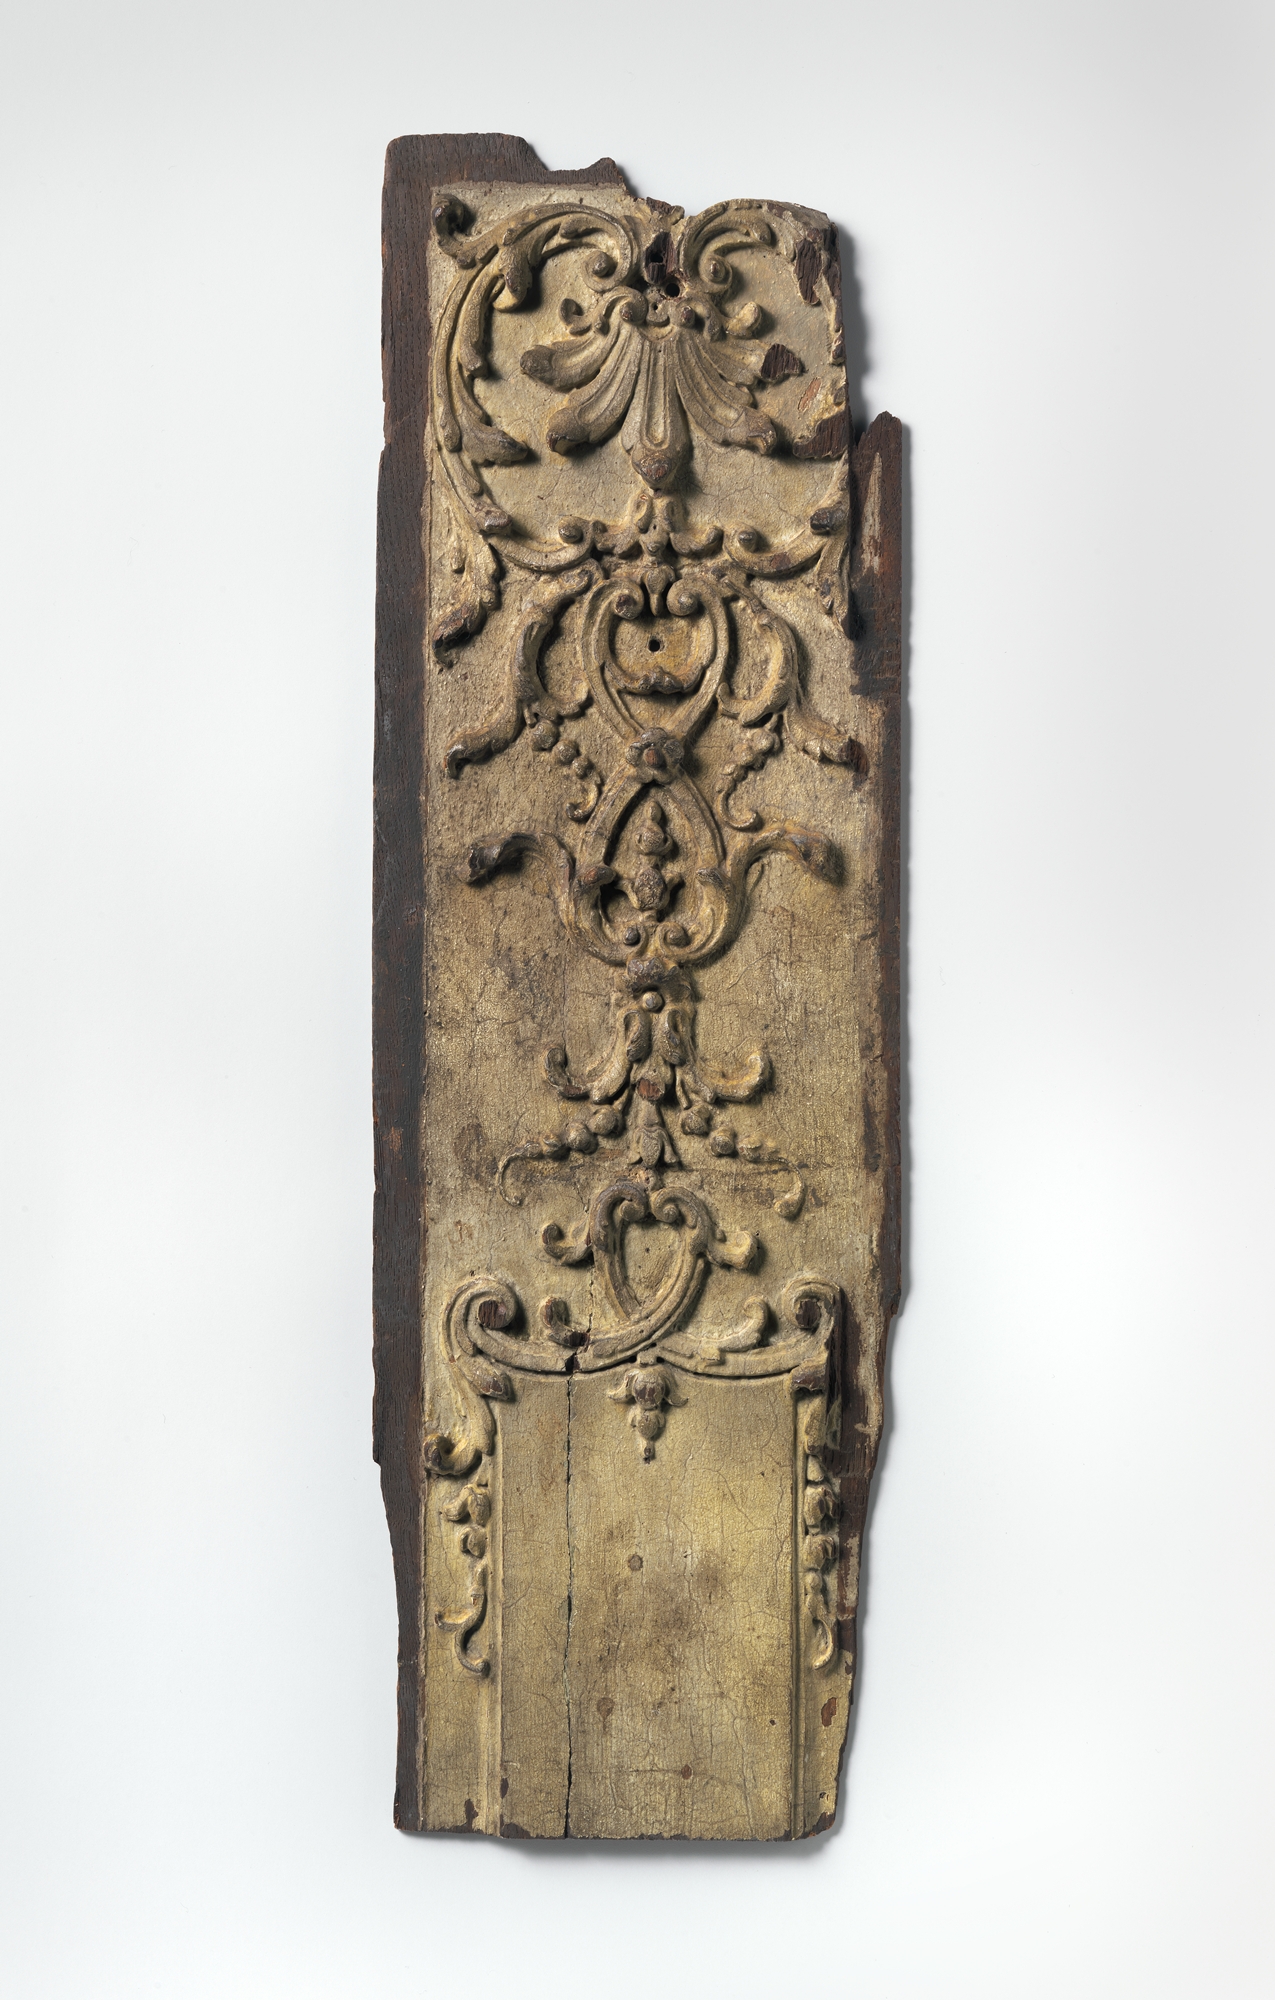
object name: pilaster fragment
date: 1701-1733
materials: wood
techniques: painting